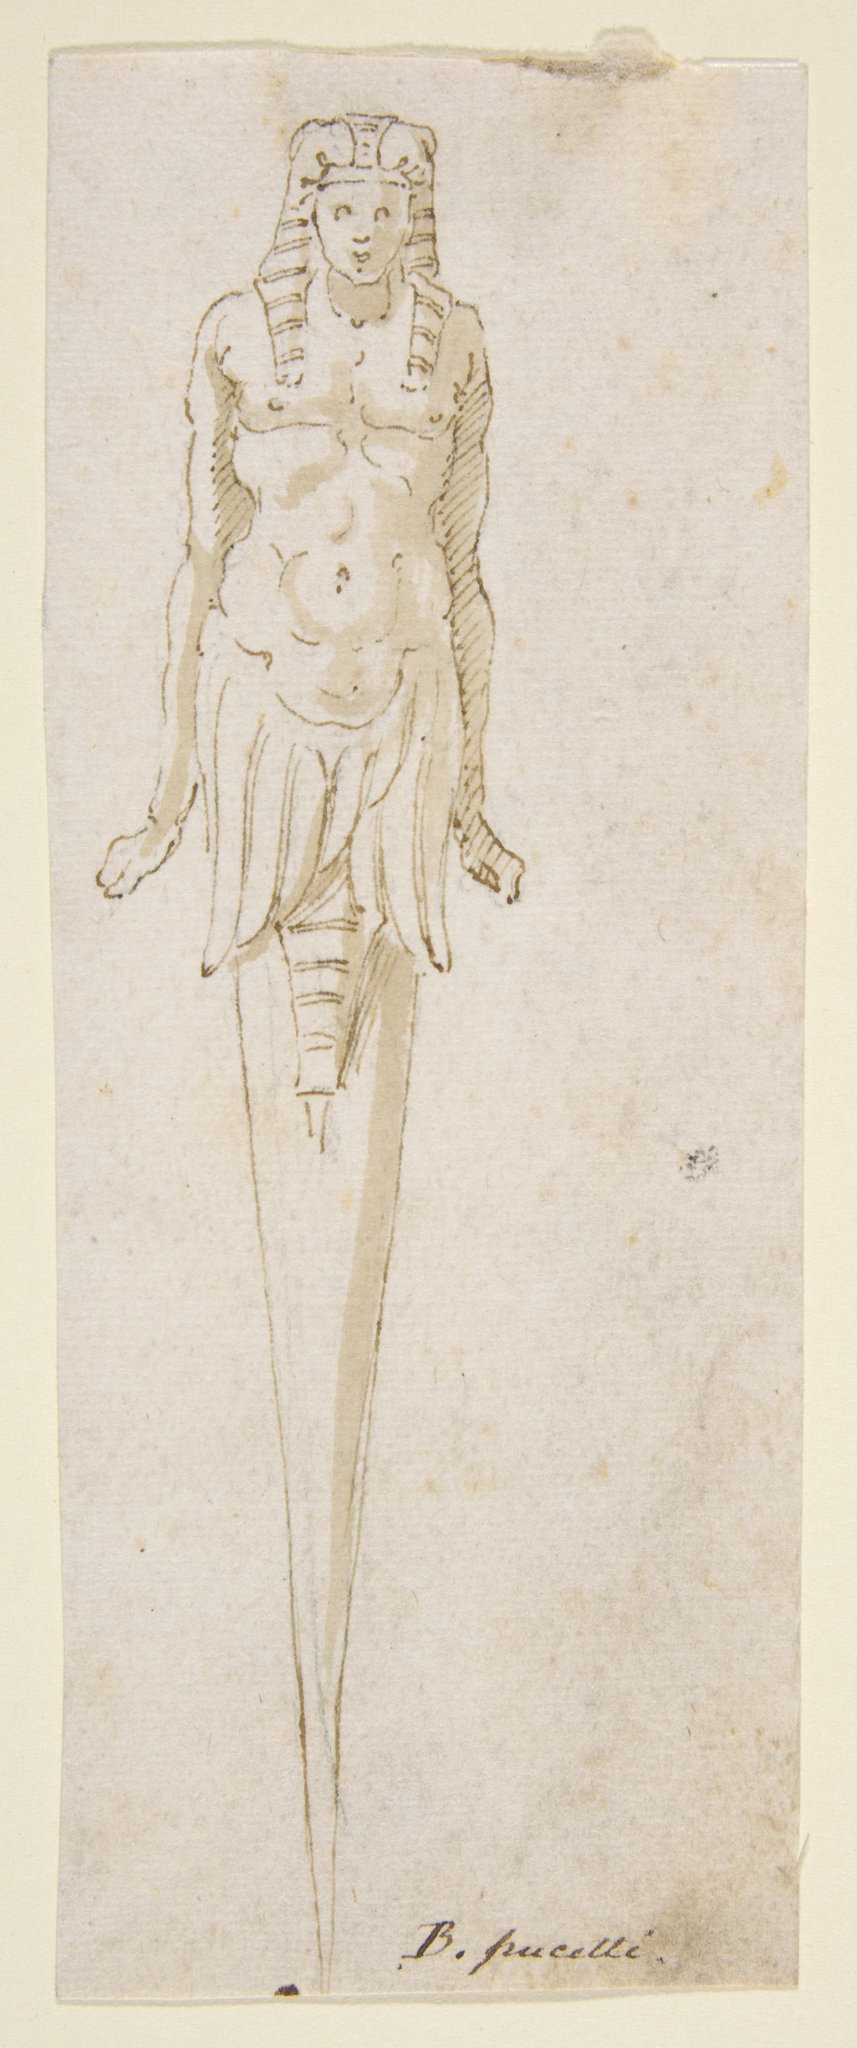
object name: drawing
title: Design for Pointed Utensil with an Egyptian Style Figure on the Handle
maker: bernardino poccetti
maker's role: artist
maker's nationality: italian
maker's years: 1548-1612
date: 1548-1612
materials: chalk, ink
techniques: brush, pen, wash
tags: men